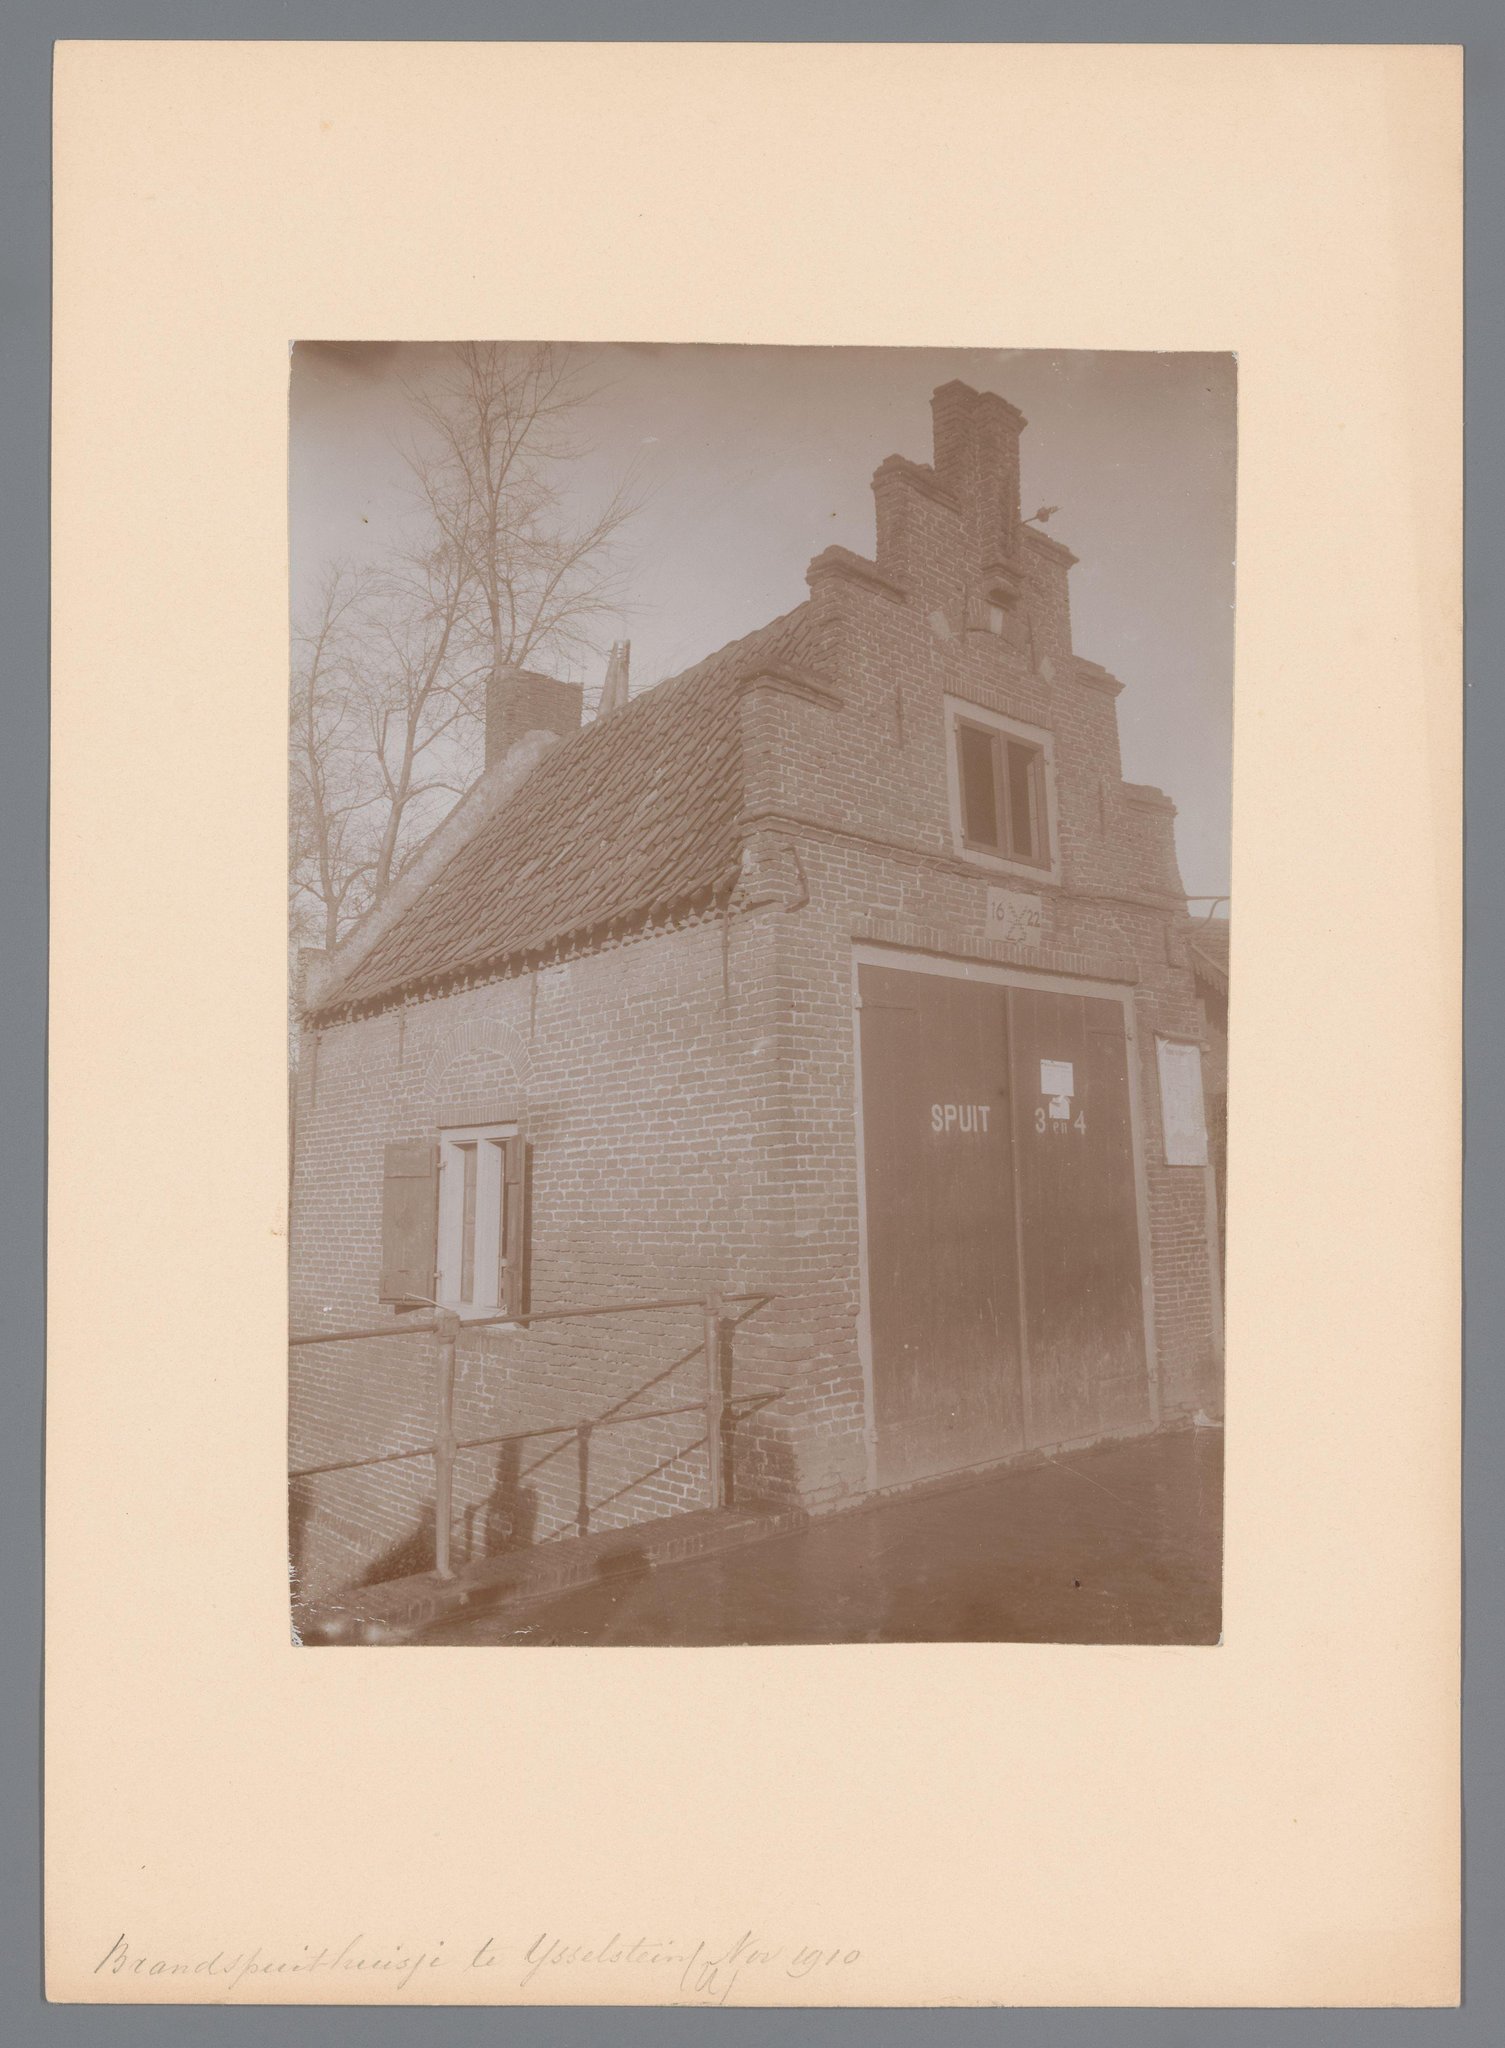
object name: photograph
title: Brandspuithuis te IJsselstein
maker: anoniem (monumentenzorg)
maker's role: fotograaf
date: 1910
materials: cardboard, photographic support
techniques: collodion silver print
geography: ijsselstein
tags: fire-department, fire-brigade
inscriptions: annotation: ‘Brandspuithuisje te IJsselstein (U.)/ Nov. 1910’